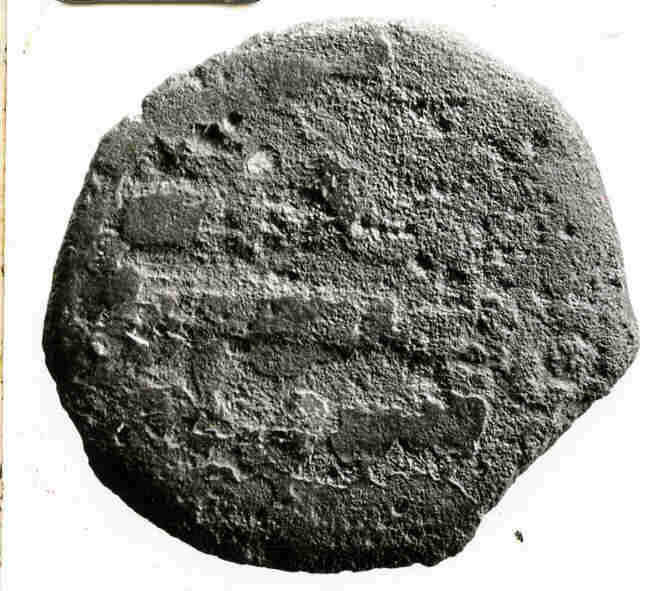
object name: coin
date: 758-768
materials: copper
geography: iran